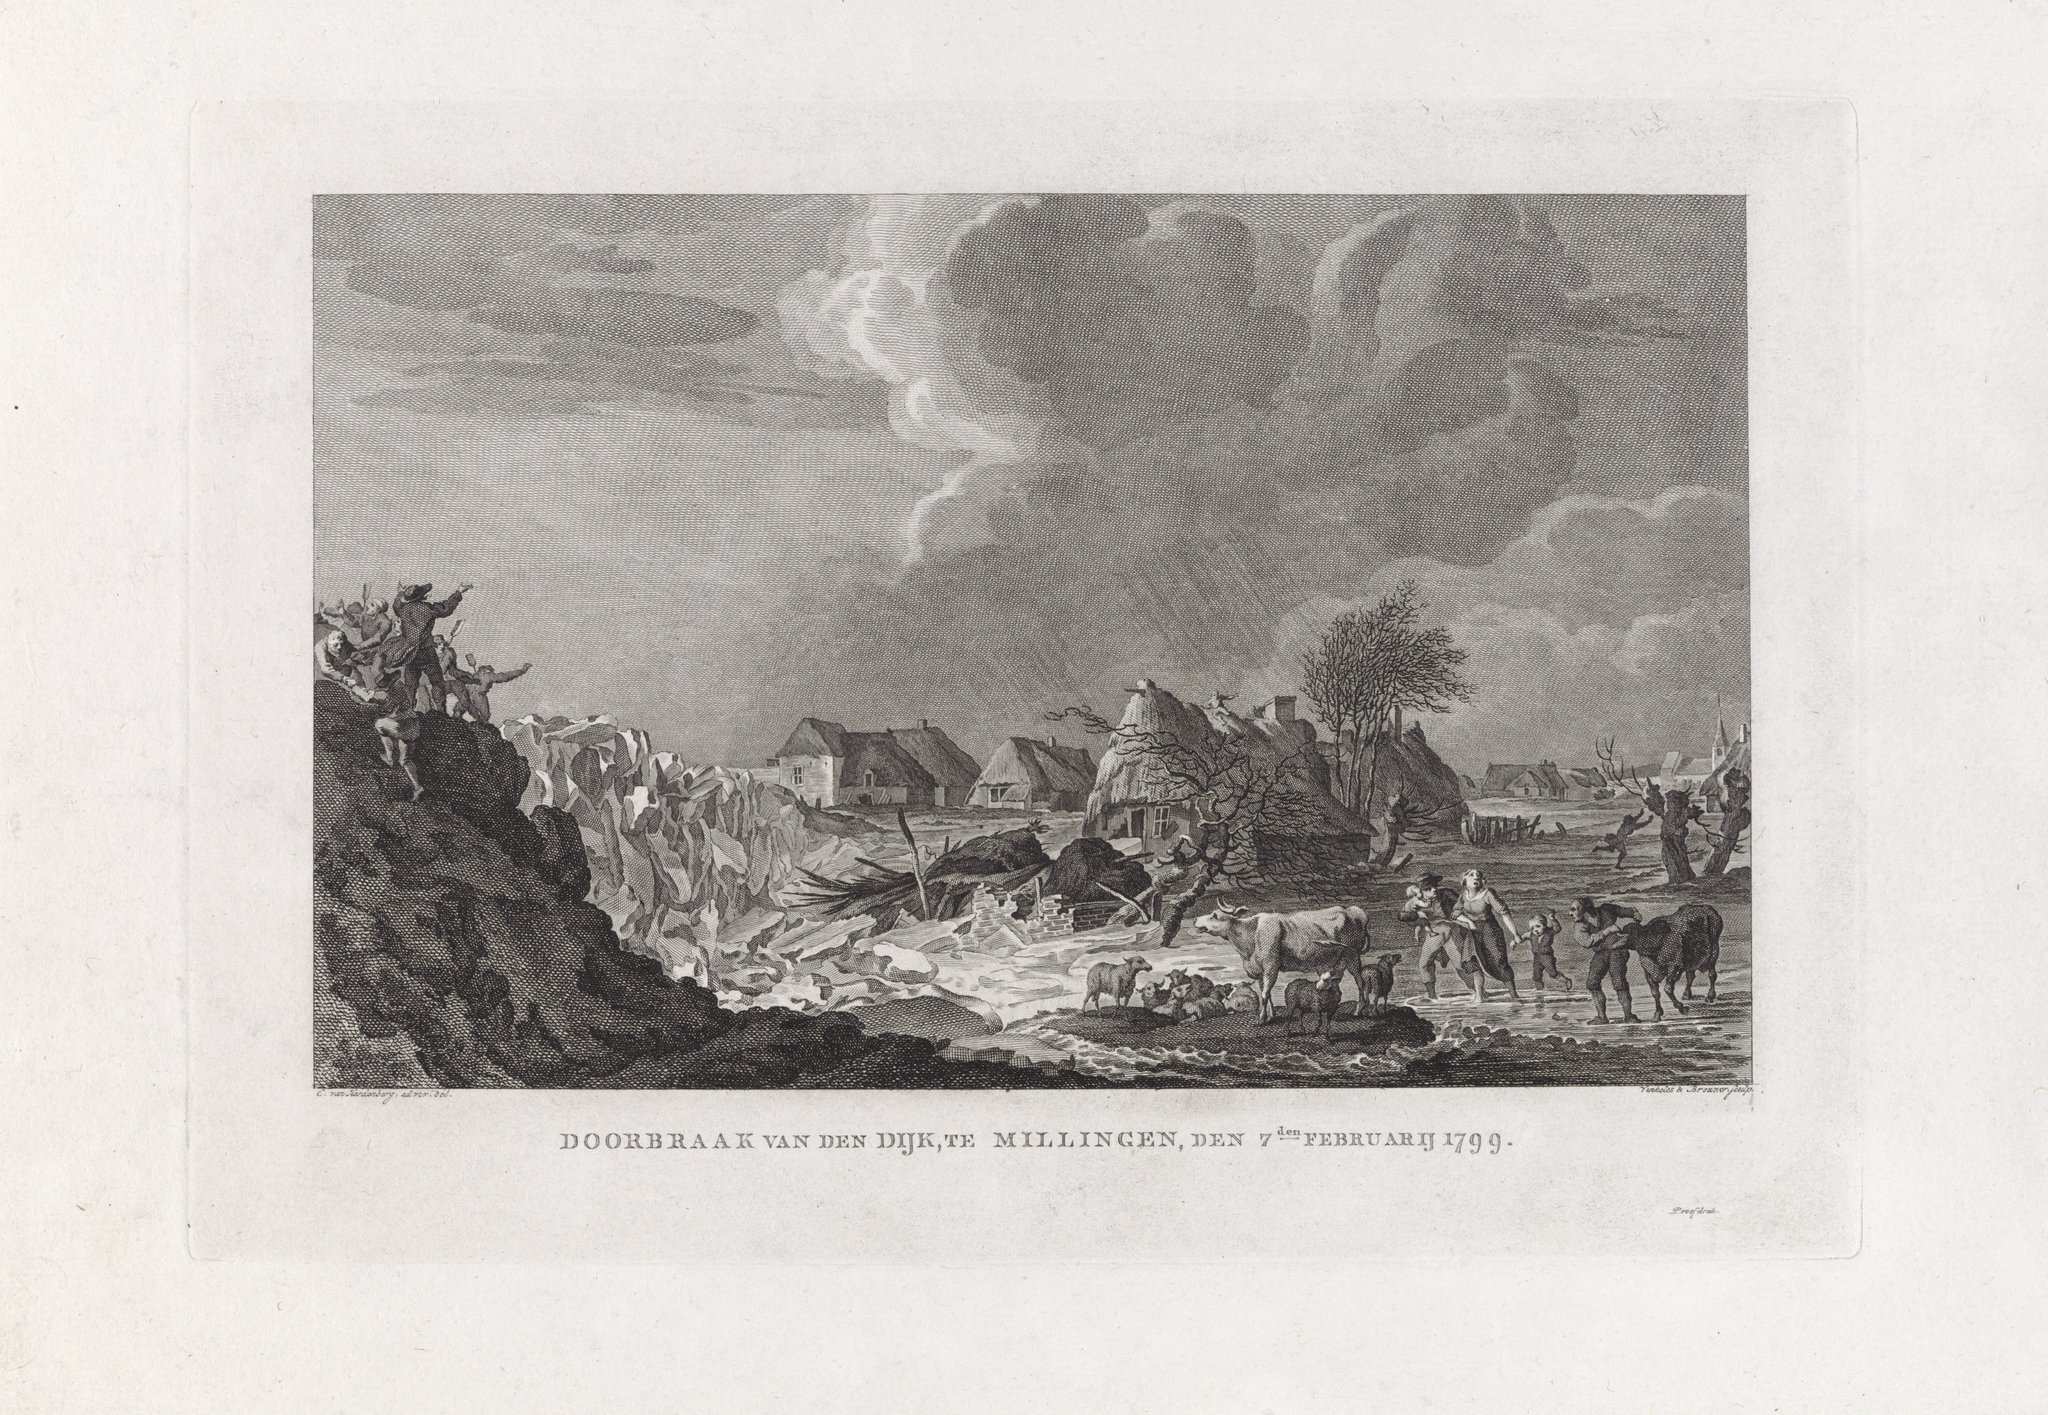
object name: print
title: Dijkdoorbraak bij Millingen, 1799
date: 1799-1800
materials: paper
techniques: engraving, etching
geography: millingen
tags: dike-break, storm on land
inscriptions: collector's mark: Lugt 2228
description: Doorbraak van Rijndijk bij Millingen, 7 februari 1799. Onderdeel van een groep van zes platen van dijkdoorbraken en watersnood in het zuidelijk deel van Gelderland in februari 1799.